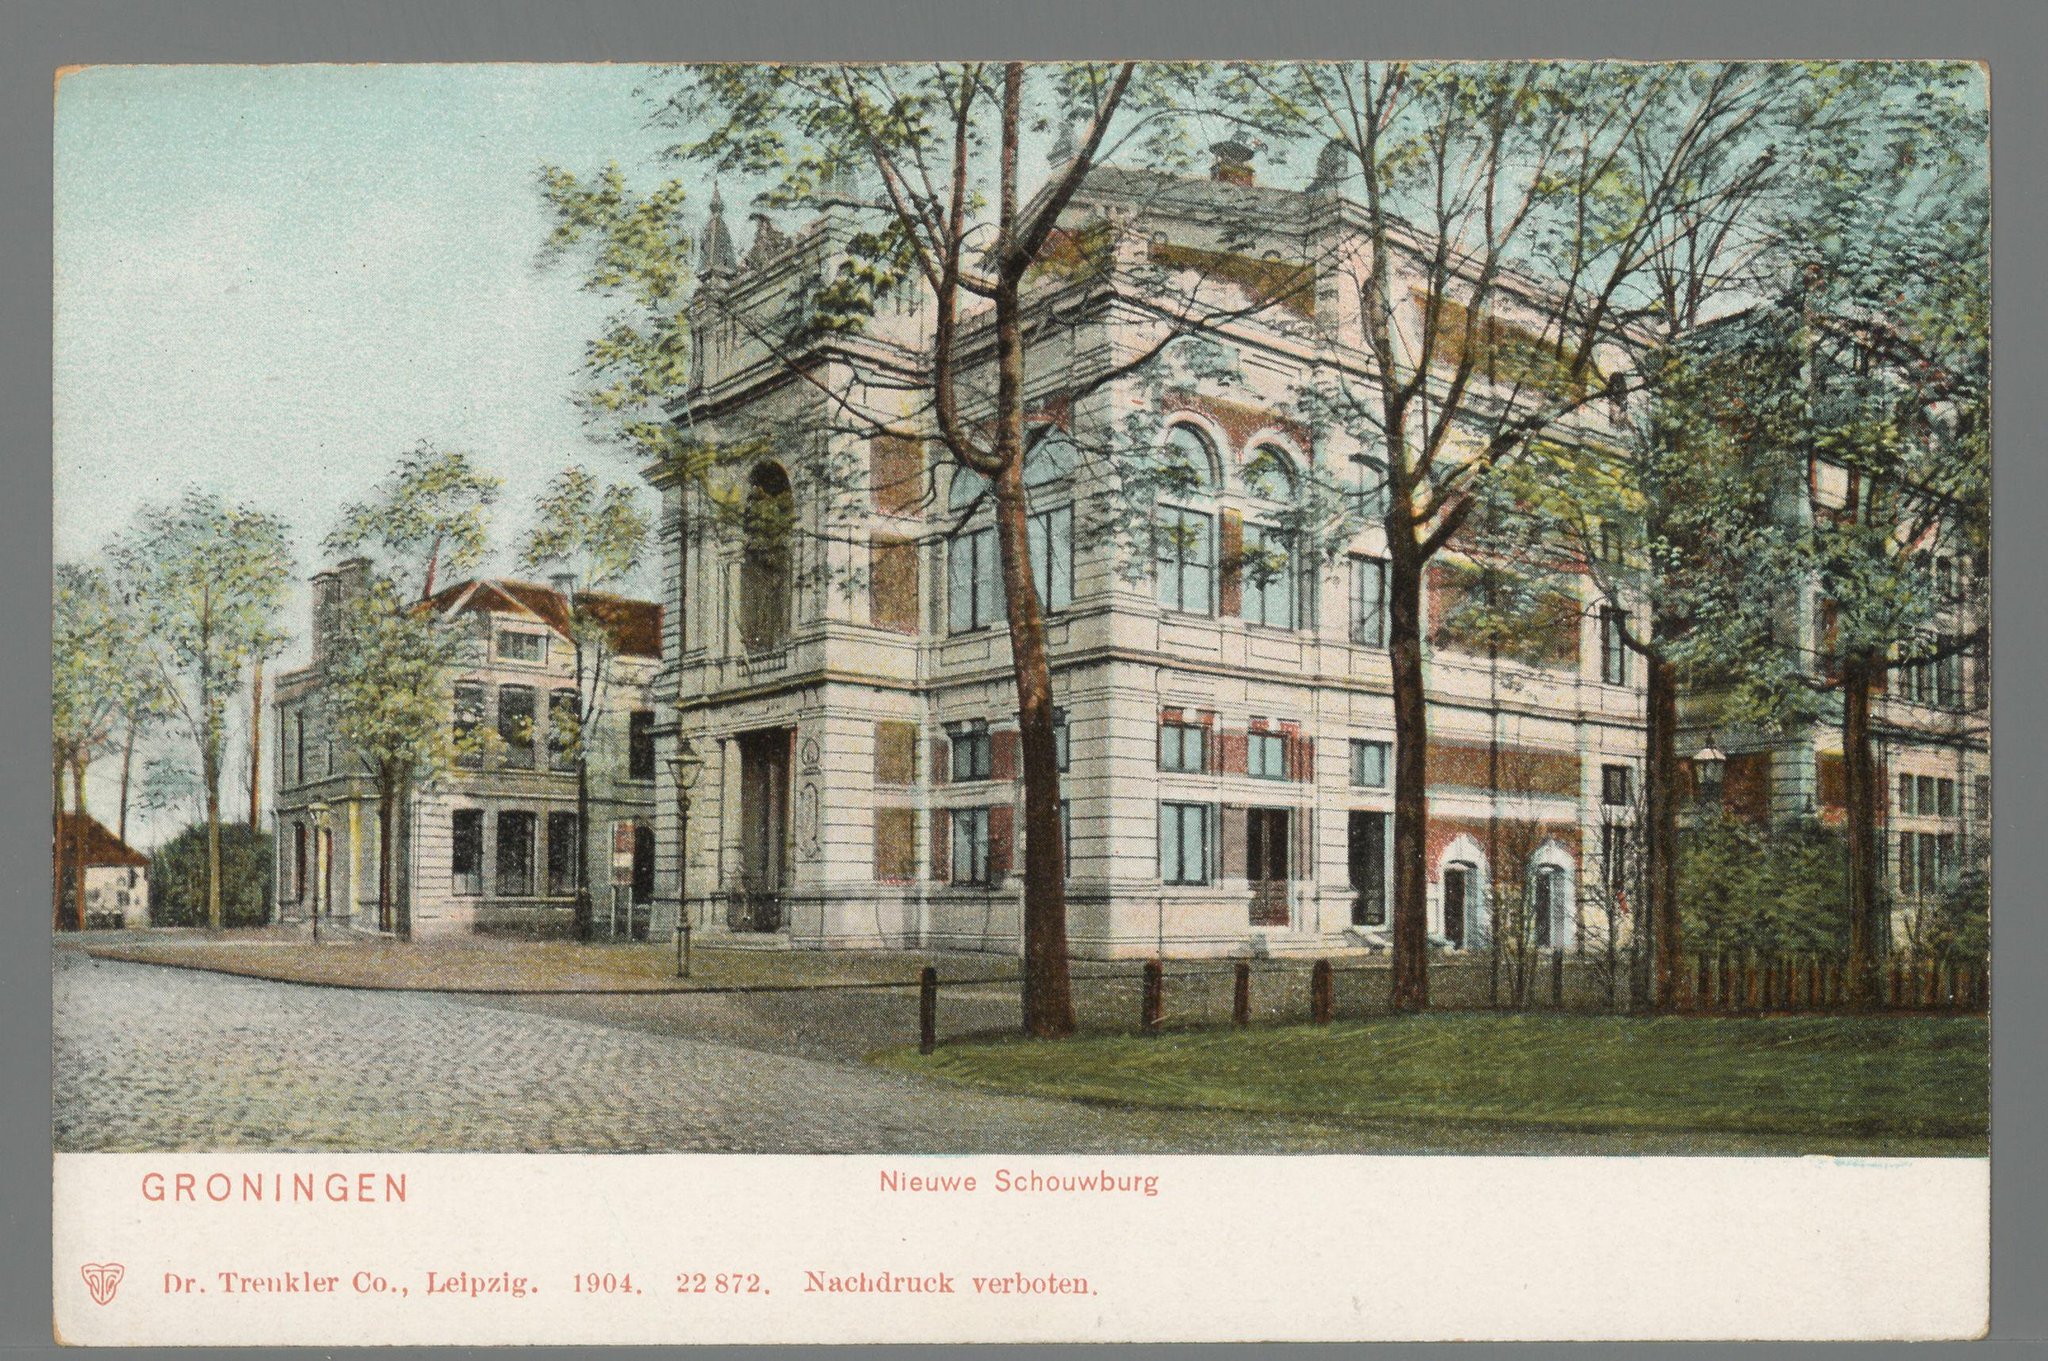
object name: ansichtkaart, prentbriefkaart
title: Groningen. Nieuwe Schouwburg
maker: Anonymous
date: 1904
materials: cardboard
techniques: lithograph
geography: leipzig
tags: theatre (building)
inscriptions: date